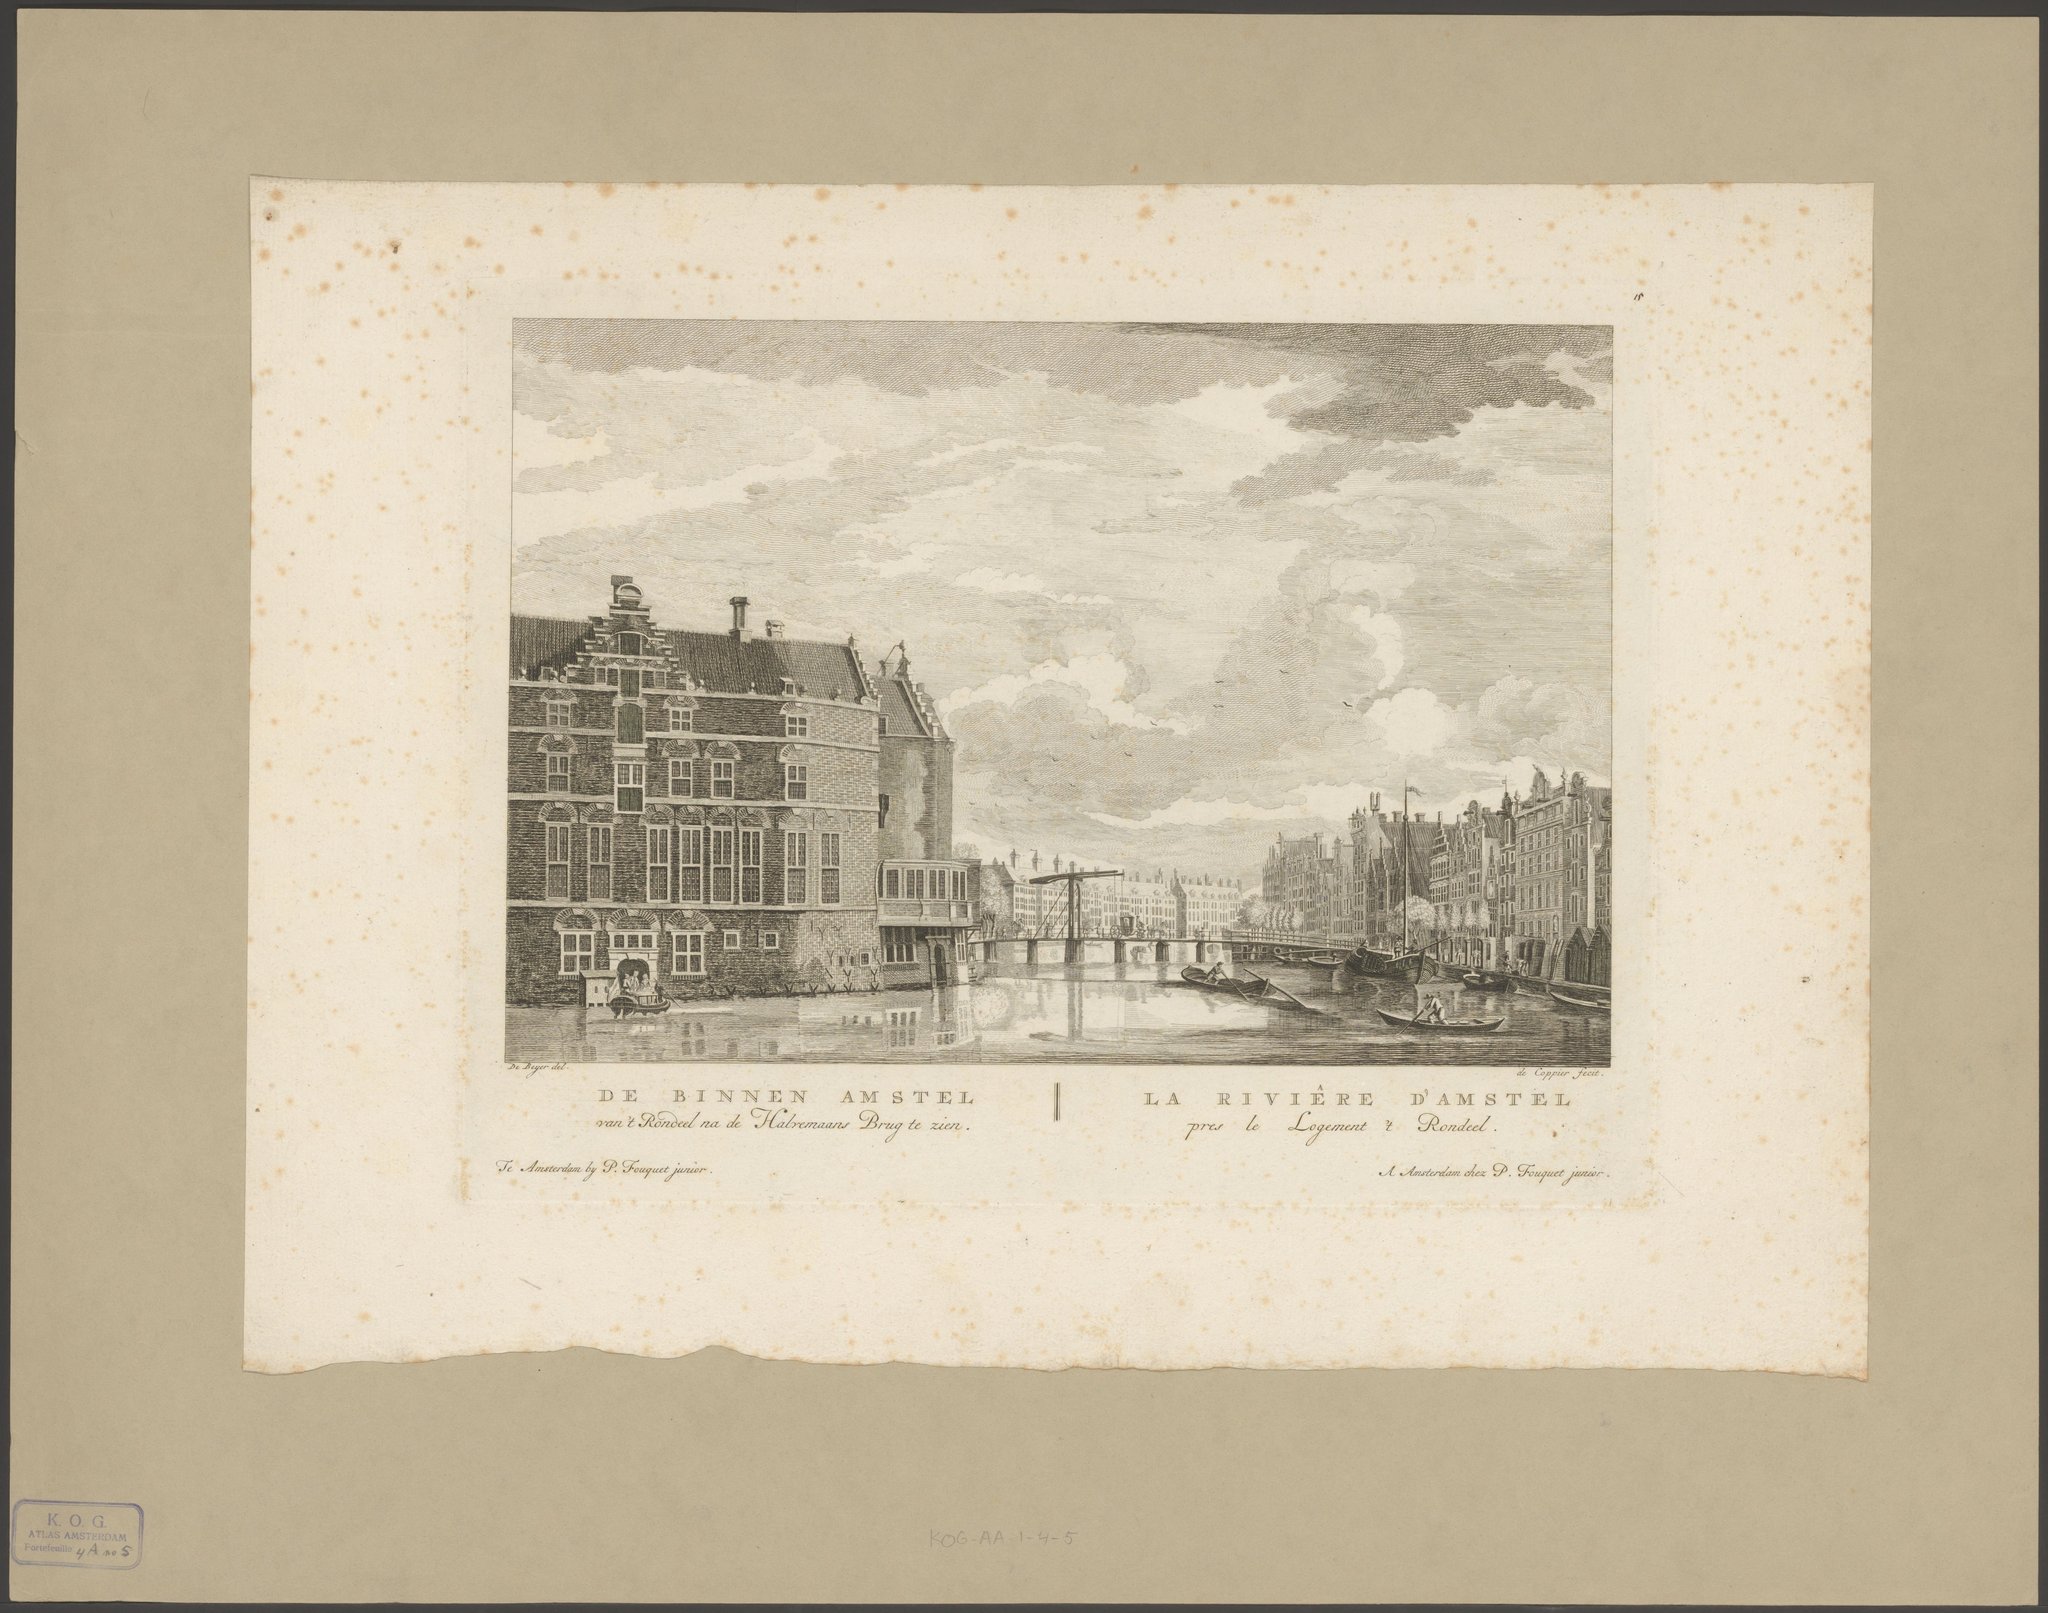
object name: print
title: De Binnen Amstel van 't Rondeel na de Halvemaans Brug te zien / La riviêre d'Amstel pres le logement 't Rondeel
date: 1774-1783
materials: paper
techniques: engraving, etching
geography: amsterdam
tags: city-view in general; 'veduta', canal, façade (of house or building), bridge in city across river, canal, etc., boat propelled by man or animal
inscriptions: number: ‘15’, collector's mark: ‘4A no 5’ Lugt 1641b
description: Deze prent is ook gebruikt in de zogenaamde Atlas van Fouquet.* Pierre Fouquet gaf vanaf 1760 stadsgezichten van Amsterdam - naar tekeningen van verschillende kunstenaars, gemaakt door verschillende prentmakers - uit. Deze prenten werden aanvankelijk los of in series verkocht. Zoals toen gebruikelijk kon de koper de prenten zelf laten inbinden. Hiertoe gaf Fouquet tussen 1778 en 1783 een titelblad, plattegrond en inhoudsopgave van de tot dusver 100 uitgegeven prenten uit (1). Gezien de inhoud afhankelijk was van wat de koper had verzameld verschilt de inhoud van de verschillende bewaarde Fouquetatlassen onder deze titel sterk. Ook zijn er exemplaren bekend waar tevens andere prenten aan zijn toegevoegd. Omdat er behoefte bleek aan uitleg bij de platen werd in 1783 een nieuwe versie van de atlas uitgegeven, aangevuld met tekst en twee prenten. De aangegeven volgorde veranderde maar de platen van de al eerder uitgegeven prenten bleven ongewijzigd. Deze uitgave werd in opdracht van Fouquet gedrukt bij Daniël Jean Changuion en Petrus den Hengst (2). Een tiental platen werd bijgewerkt en verscheen, met nieuw impressum, in het vervolg van Wagenaars geschiedenis van Amsterdam, uitgeven door Petrus Conradi en Folkert van der Plaats (3). Een aantal jaar na het overlijden van Fouquet kwam Evert Maaskamp met een nieuwe uitgave van de atlas, met verbeterde tekst en toevoeging van twee prenten. Op alle platen verwijderde hij het oude en liet hij zijn eigen impressum zetten (4). De huidige staat van de prent komt voor in exemplaren van de onder (1) en (2) genoemde werken. * Onder de Atlas van Fouquet of Fouquetatlas verstaan we de hieronder vermelde publicaties (1), (2) en (4). (1). Afbeeldingen van de wyd-vermaarde koopstad Amsterdam benevens des zelvs voornaamste gebouwen en gezigten alle naar het leeven getekend / Receuil des edifices les plus considerables et des plus belles vues, de la fameuse ville d'Amsterdam, dessinées d'après nature. Amsterdam: Pierre Fouquet, 1778-1783. (2). Nieuwe atlas, van de voornaamste gebouwen en gezigten der stad Amsterdam, met derzelver beknopte beschryvingen. 2 delen. Amsterdam: Daniël Jean Changuion en Petrus den Hengst [in opdracht van Pierre Fouquet], 1783. (3). Stijl, Simon. Amsterdam, in zyne geschiedenissen, voorregten, koophandel, gebouwen, kerkenstaat, schoolen, schutterye, gilden en regeeringe, beschreeven. Om te dienen ten vervolge op het werk van Jan Wagenaar (…). 10 delen. Amsterdam en Harlingen: Petrus Conradi en Folkert van der Plaats, 1788-1801. (4). Nieuwe atlas, van de voornaamste gebouwen en gezigten der stad Amsterdam. Met derzelver beknopte beschryvingen. Amsterdam: Evert Maaskamp, 1805. * Het aantal vermelde staten is gebaseerd op het aantal gevonden staten. Mogelijk zijn er meer staten van deze prent. Voor tweede of derde bekende staat zie RP-P-BI-6328.